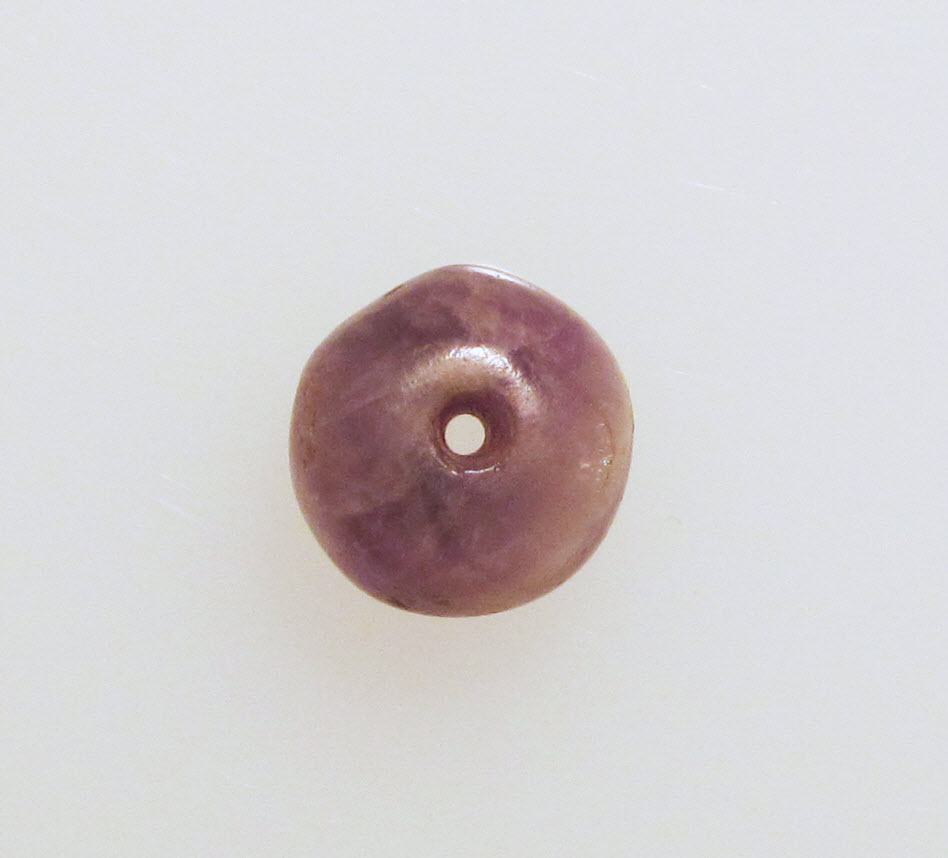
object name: bead 2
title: Beads, 2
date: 7000 BCE-330 CE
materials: gemstone